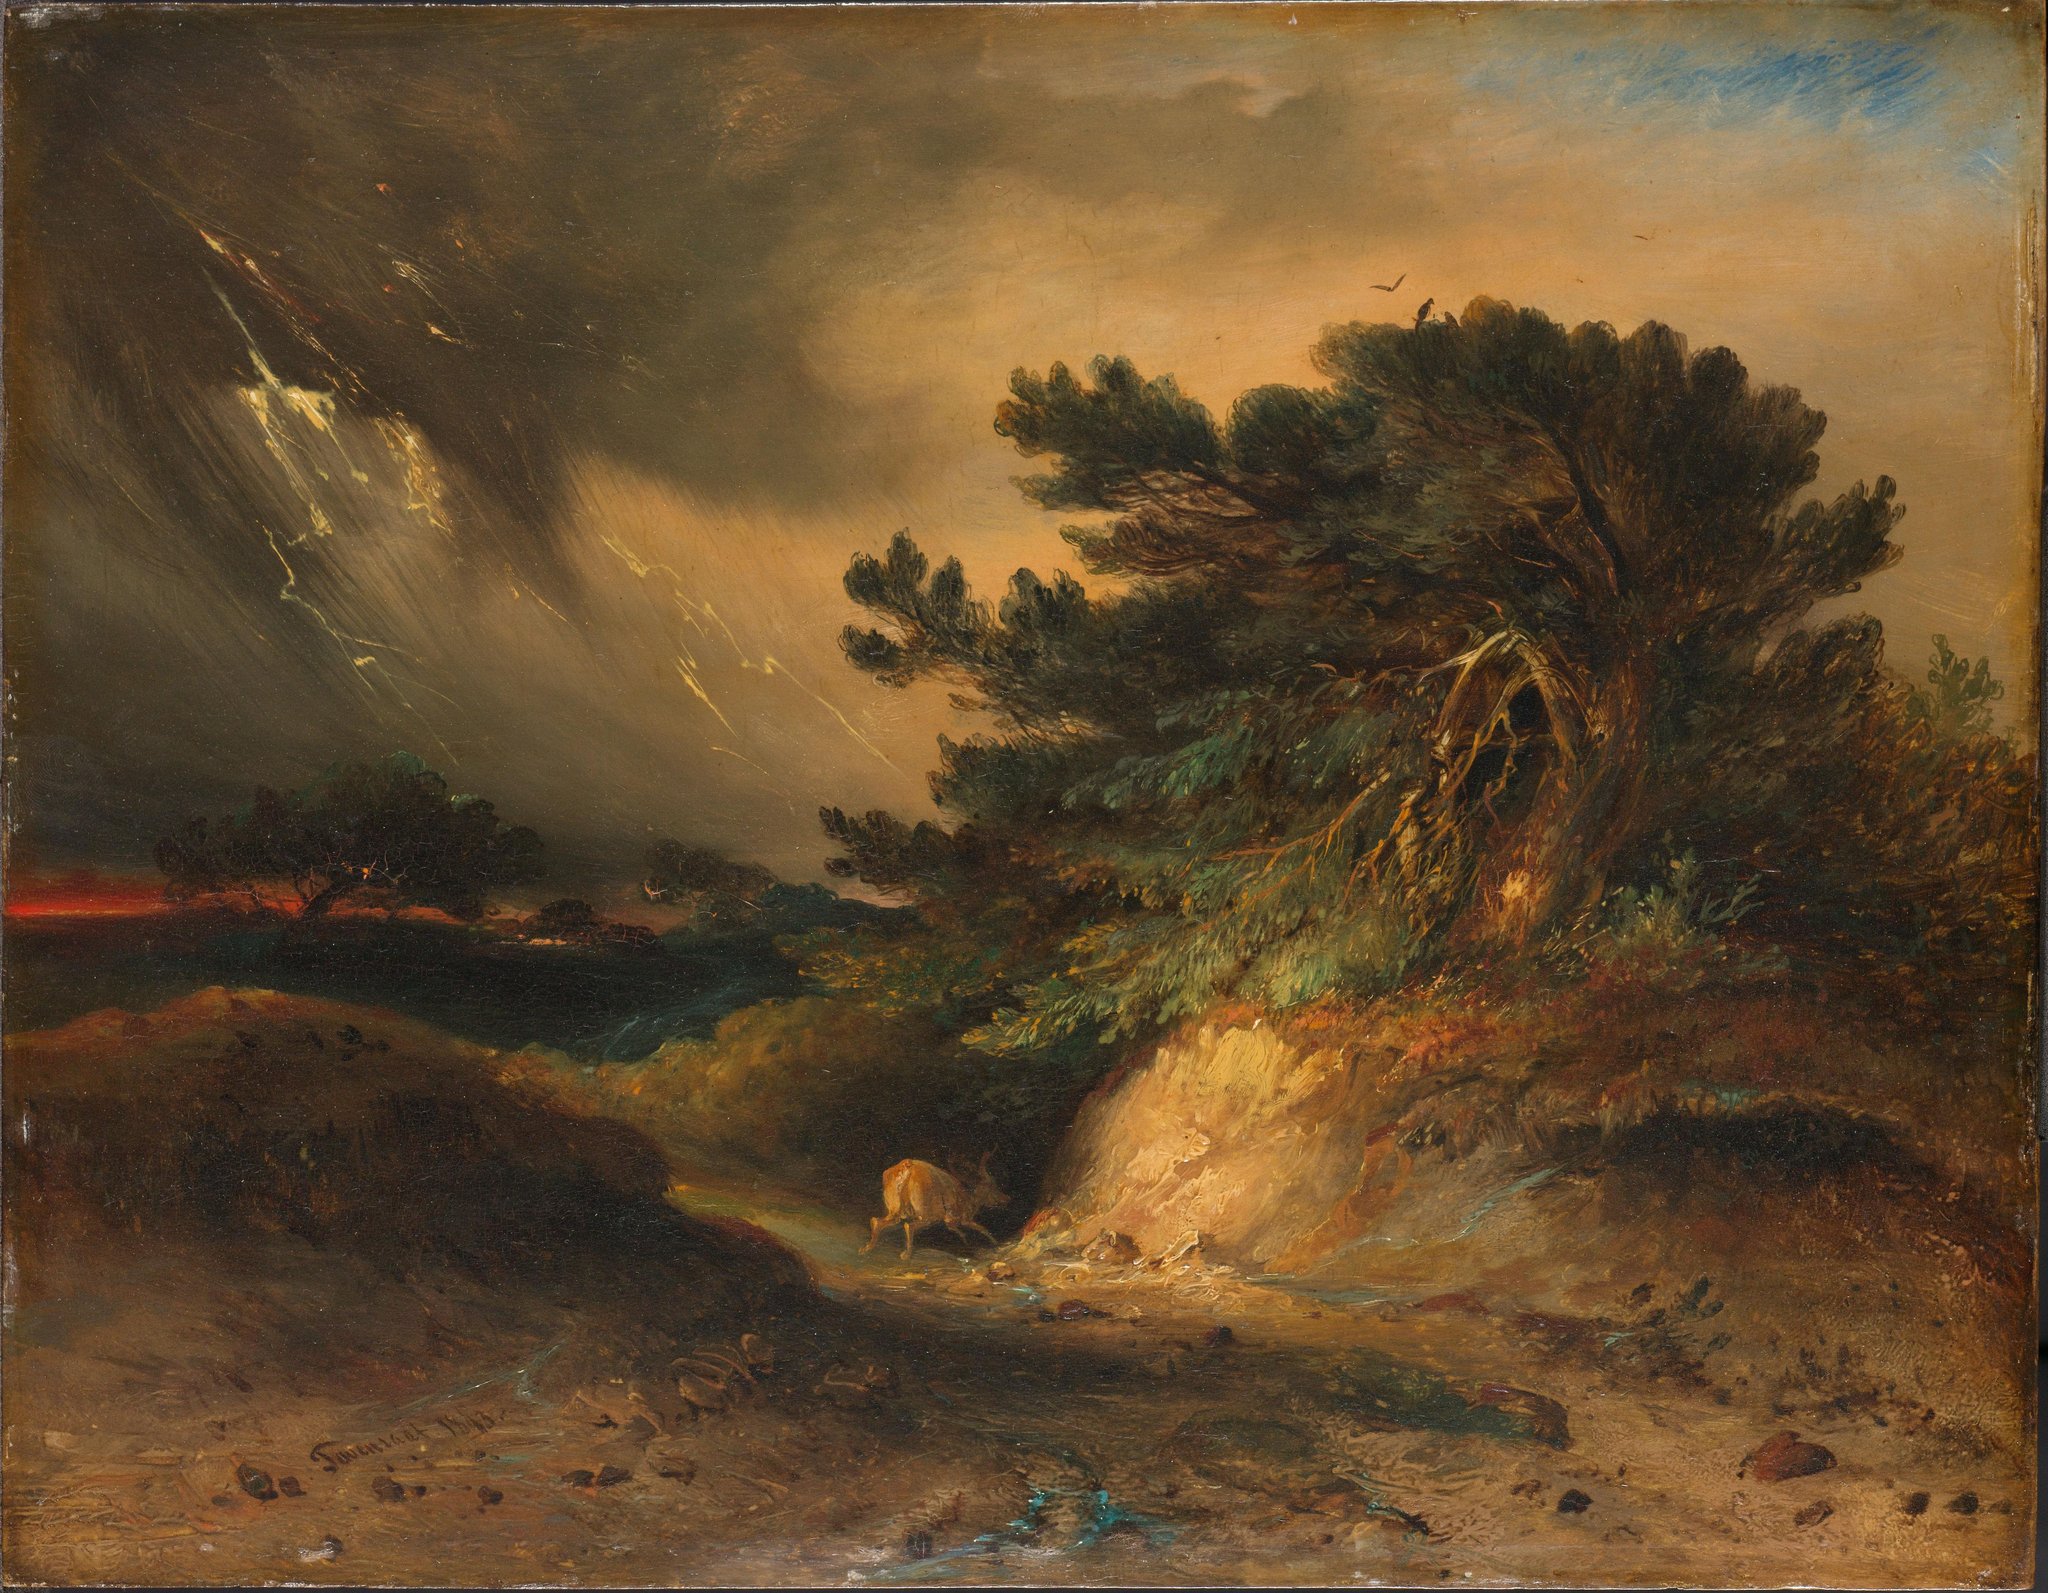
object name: painting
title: The Thunderstorm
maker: johannes tavenraat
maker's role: draughtsman, painter, print maker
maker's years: 1809-1881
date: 1843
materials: oil, panel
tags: hoofed animals: deer, landscapes in the temperate zone, thunderstorm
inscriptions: signature and date: ‘Tavenraat 1843’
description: The rapid, powerful brushwork of this landscape makes it look more like an oil sketch than a finished painting. As such, Tavenraat deviated from the path taken by most Dutch painters at the time. Instead of a smooth painting style and restrained sentiment, he opted for bright colours and dramatic effects of light and dark. His work thus more closely reflects international, mainly French, developments in Romantic painting.